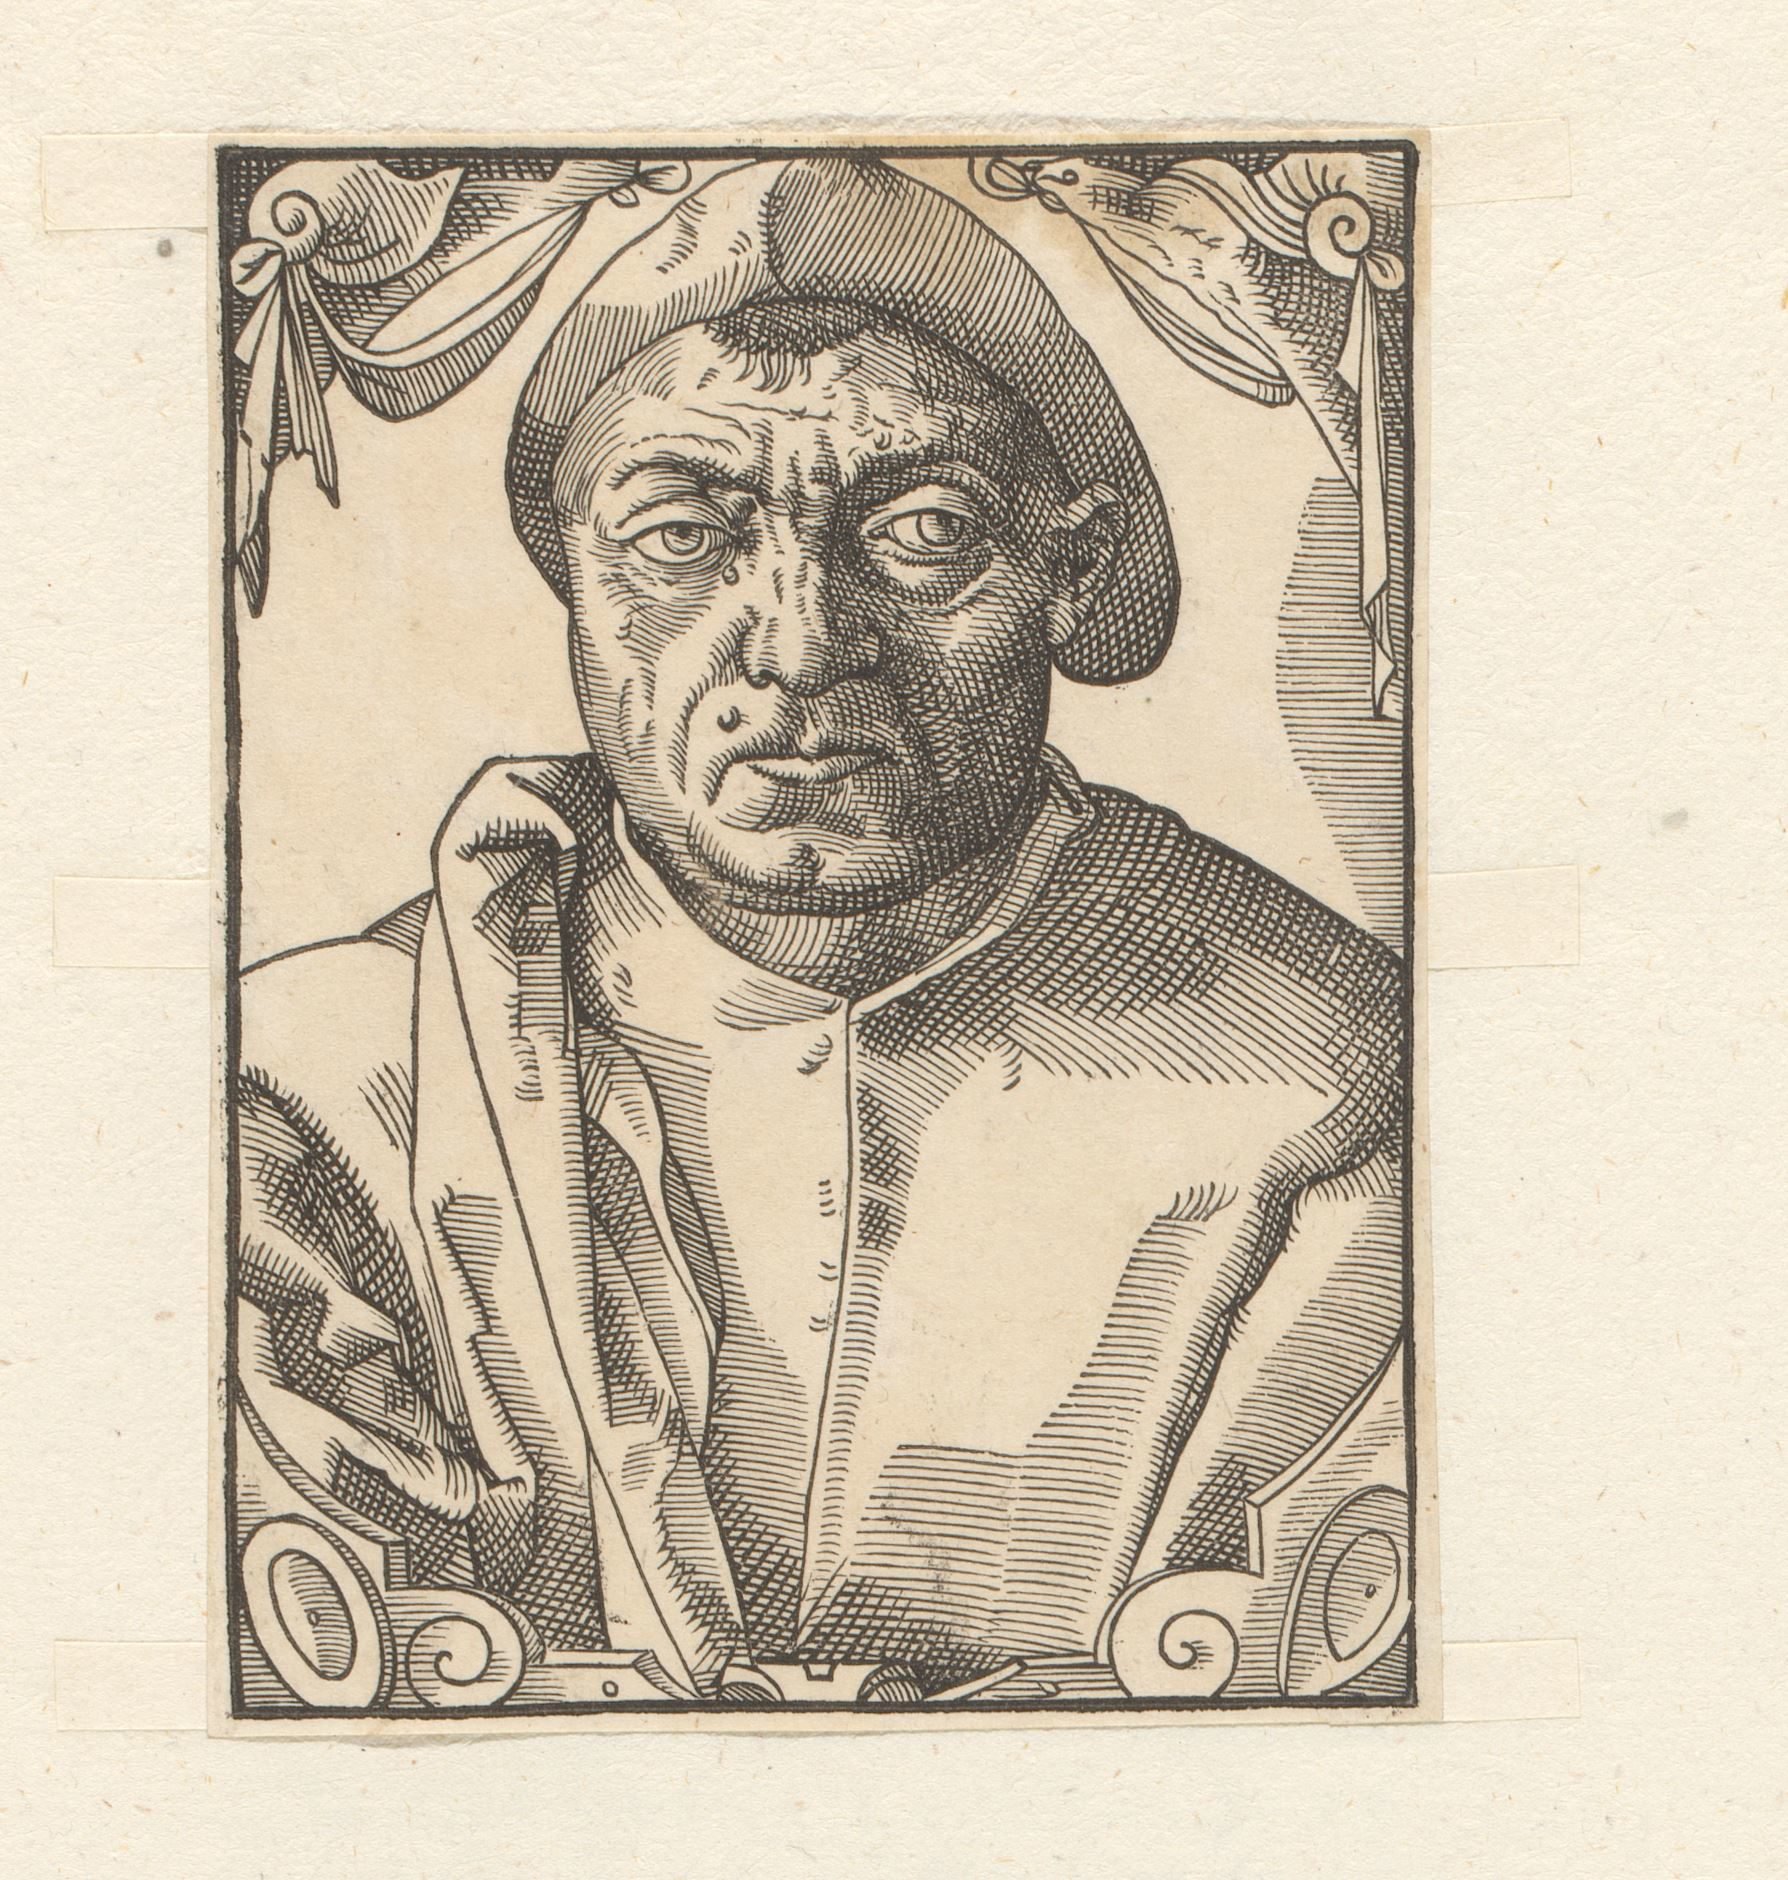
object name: book illustration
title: Portret van Petrus Montanus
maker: Anonymous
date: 1549-1584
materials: paper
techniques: woodcut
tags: historical persons, writer, poet, author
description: Prent gebruikt in: Reusner, Nikolaus. Icones Sive Imagines Vivae. Bazel: Conrad Waldkirch, 1589.